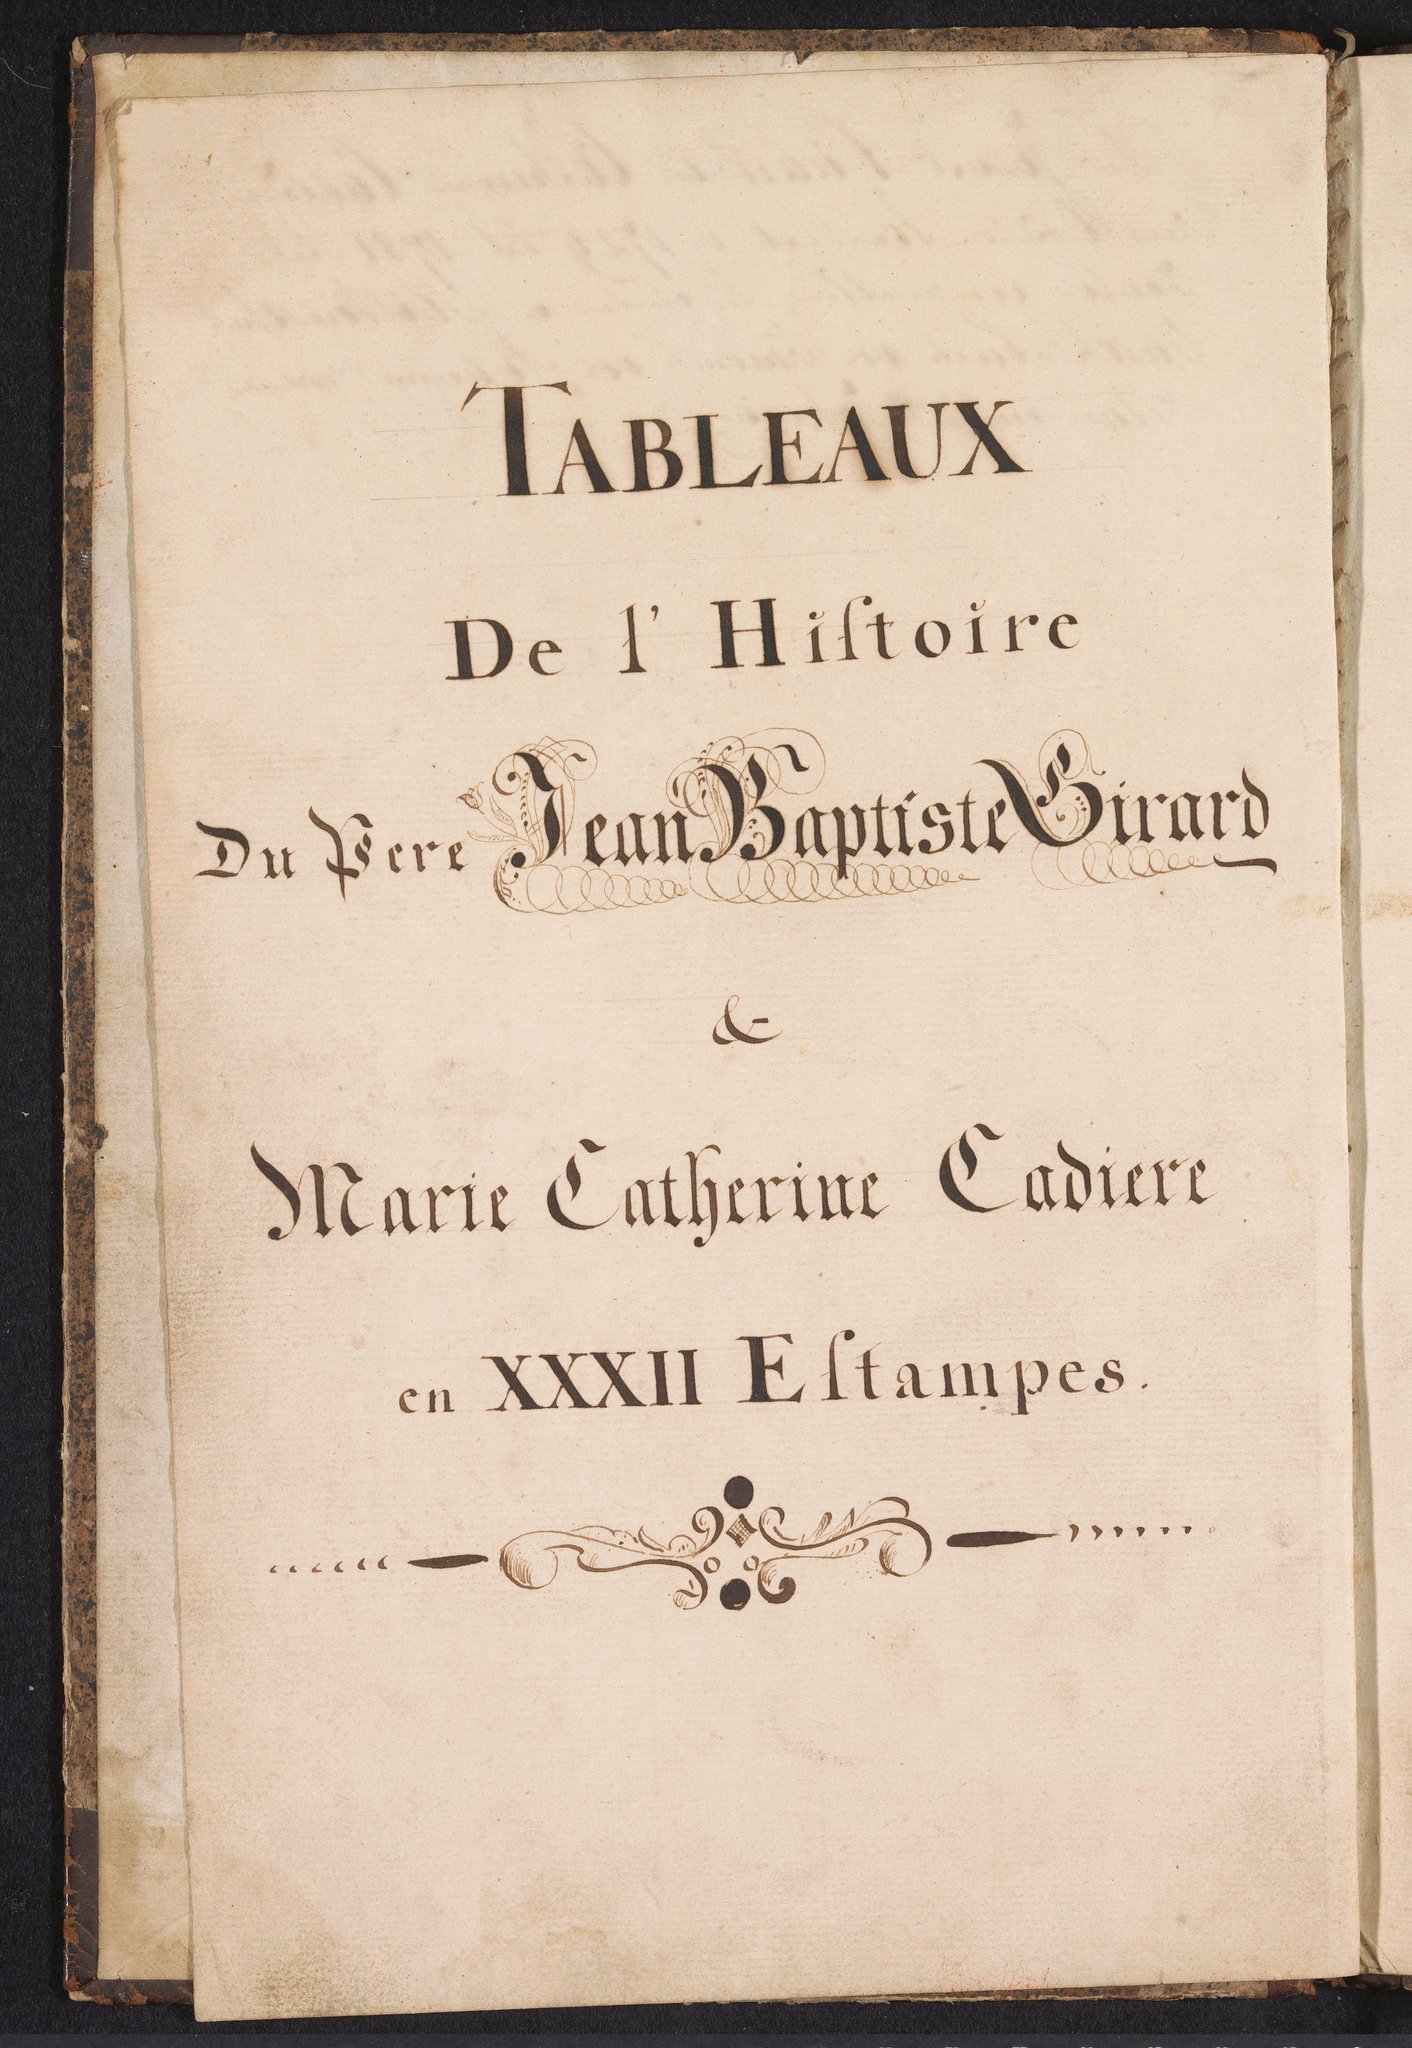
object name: manuscript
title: Titel voor de prentenserie over de affaire Marie-Catherine Cadière en Jean-Baptiste Girard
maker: Anonymous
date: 1735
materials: paper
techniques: handwriting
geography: france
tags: witch, sorcerer with the devil and/or demons, sexual abuses of monks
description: Handgeschreven titelpagina voor de reeks van 32, veelal erotisch getinte, prenten gewijd aan het schandaal rond Marie-Catherine Cadière en de Jezuïet Jean-Baptiste Girard in 1730-1731.